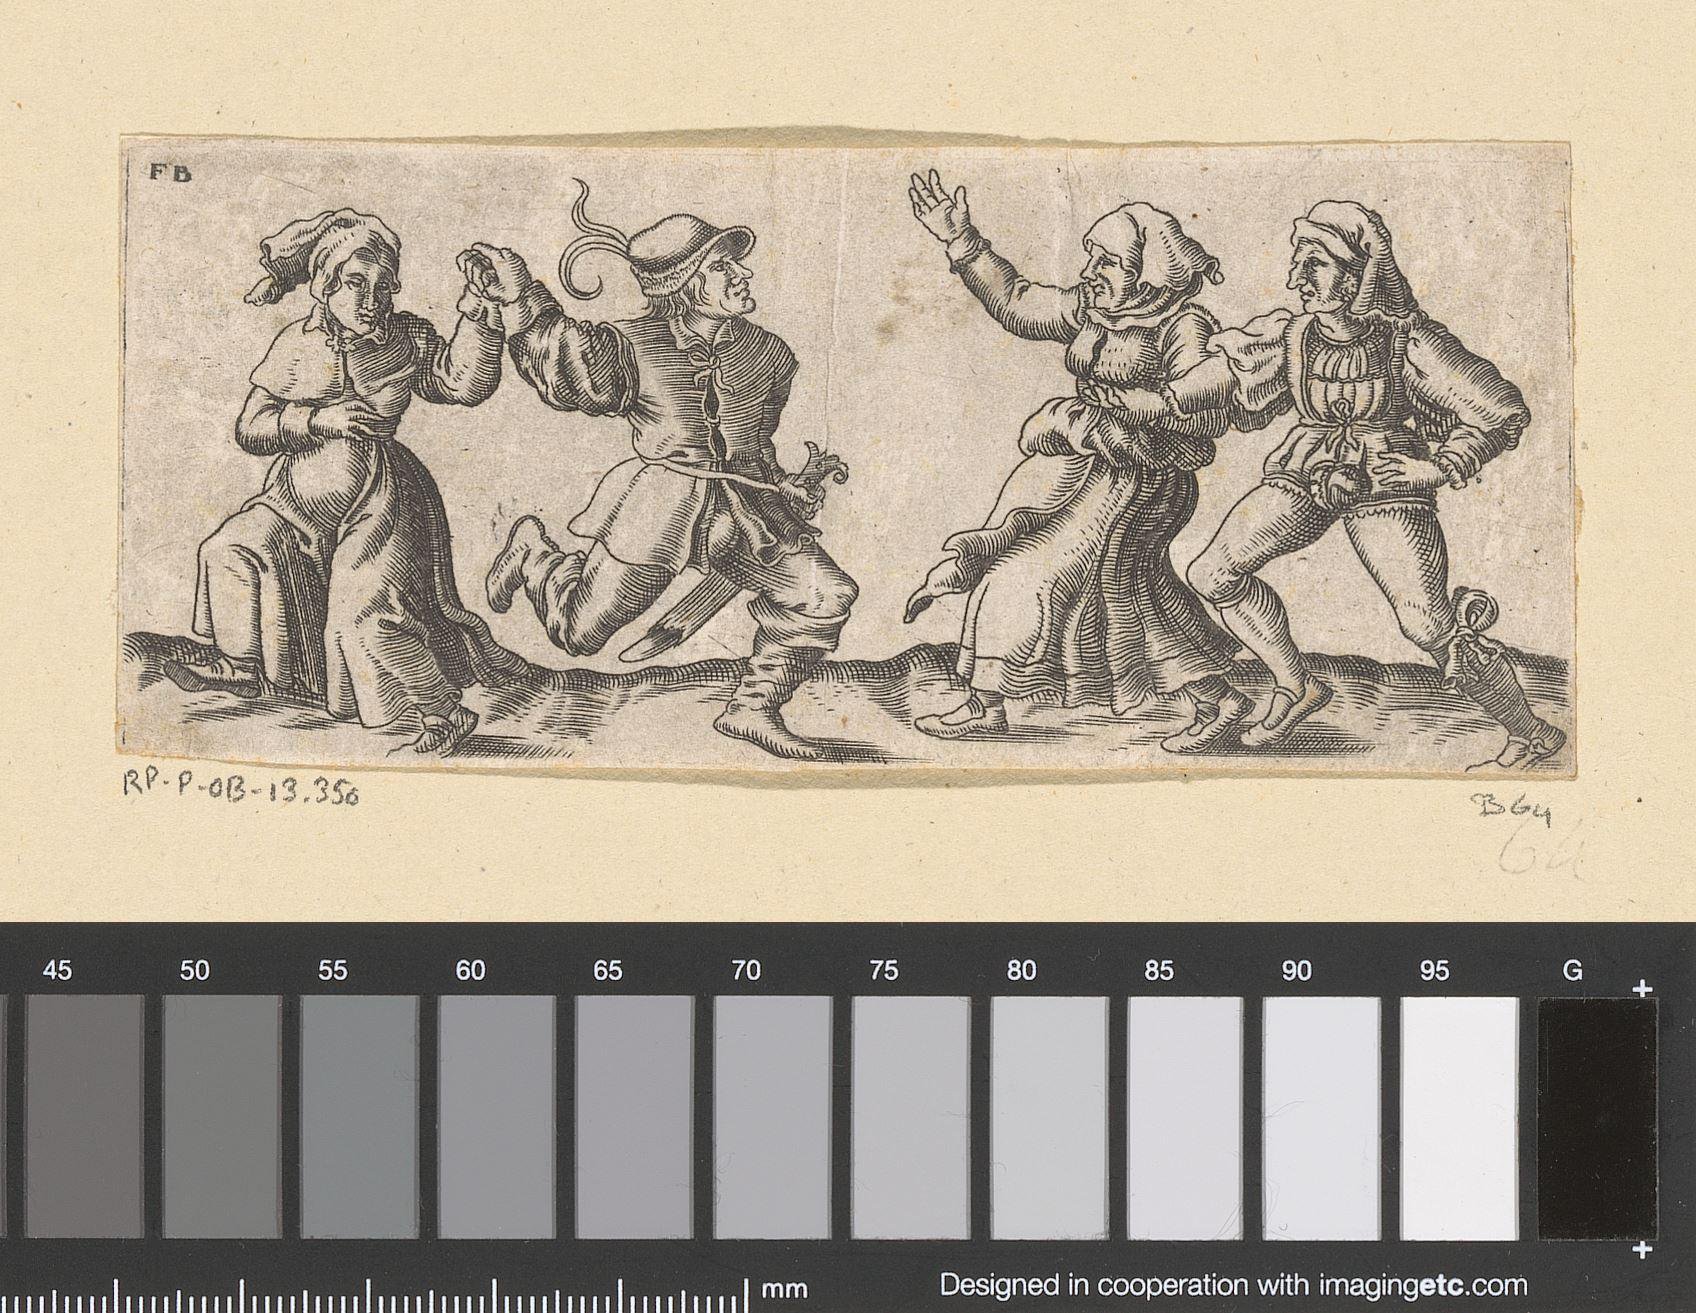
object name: print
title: Dansende boeren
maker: franz isaac brun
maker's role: print maker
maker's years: 1535-1620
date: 1559-1596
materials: paper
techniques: engraving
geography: germany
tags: dancing, farmers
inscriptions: collector's mark: Lugt 240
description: Deze prent maakt deel uit van een serie van twaalf prenten met dansende boeren in de stijl van Hans Sebald Beham.